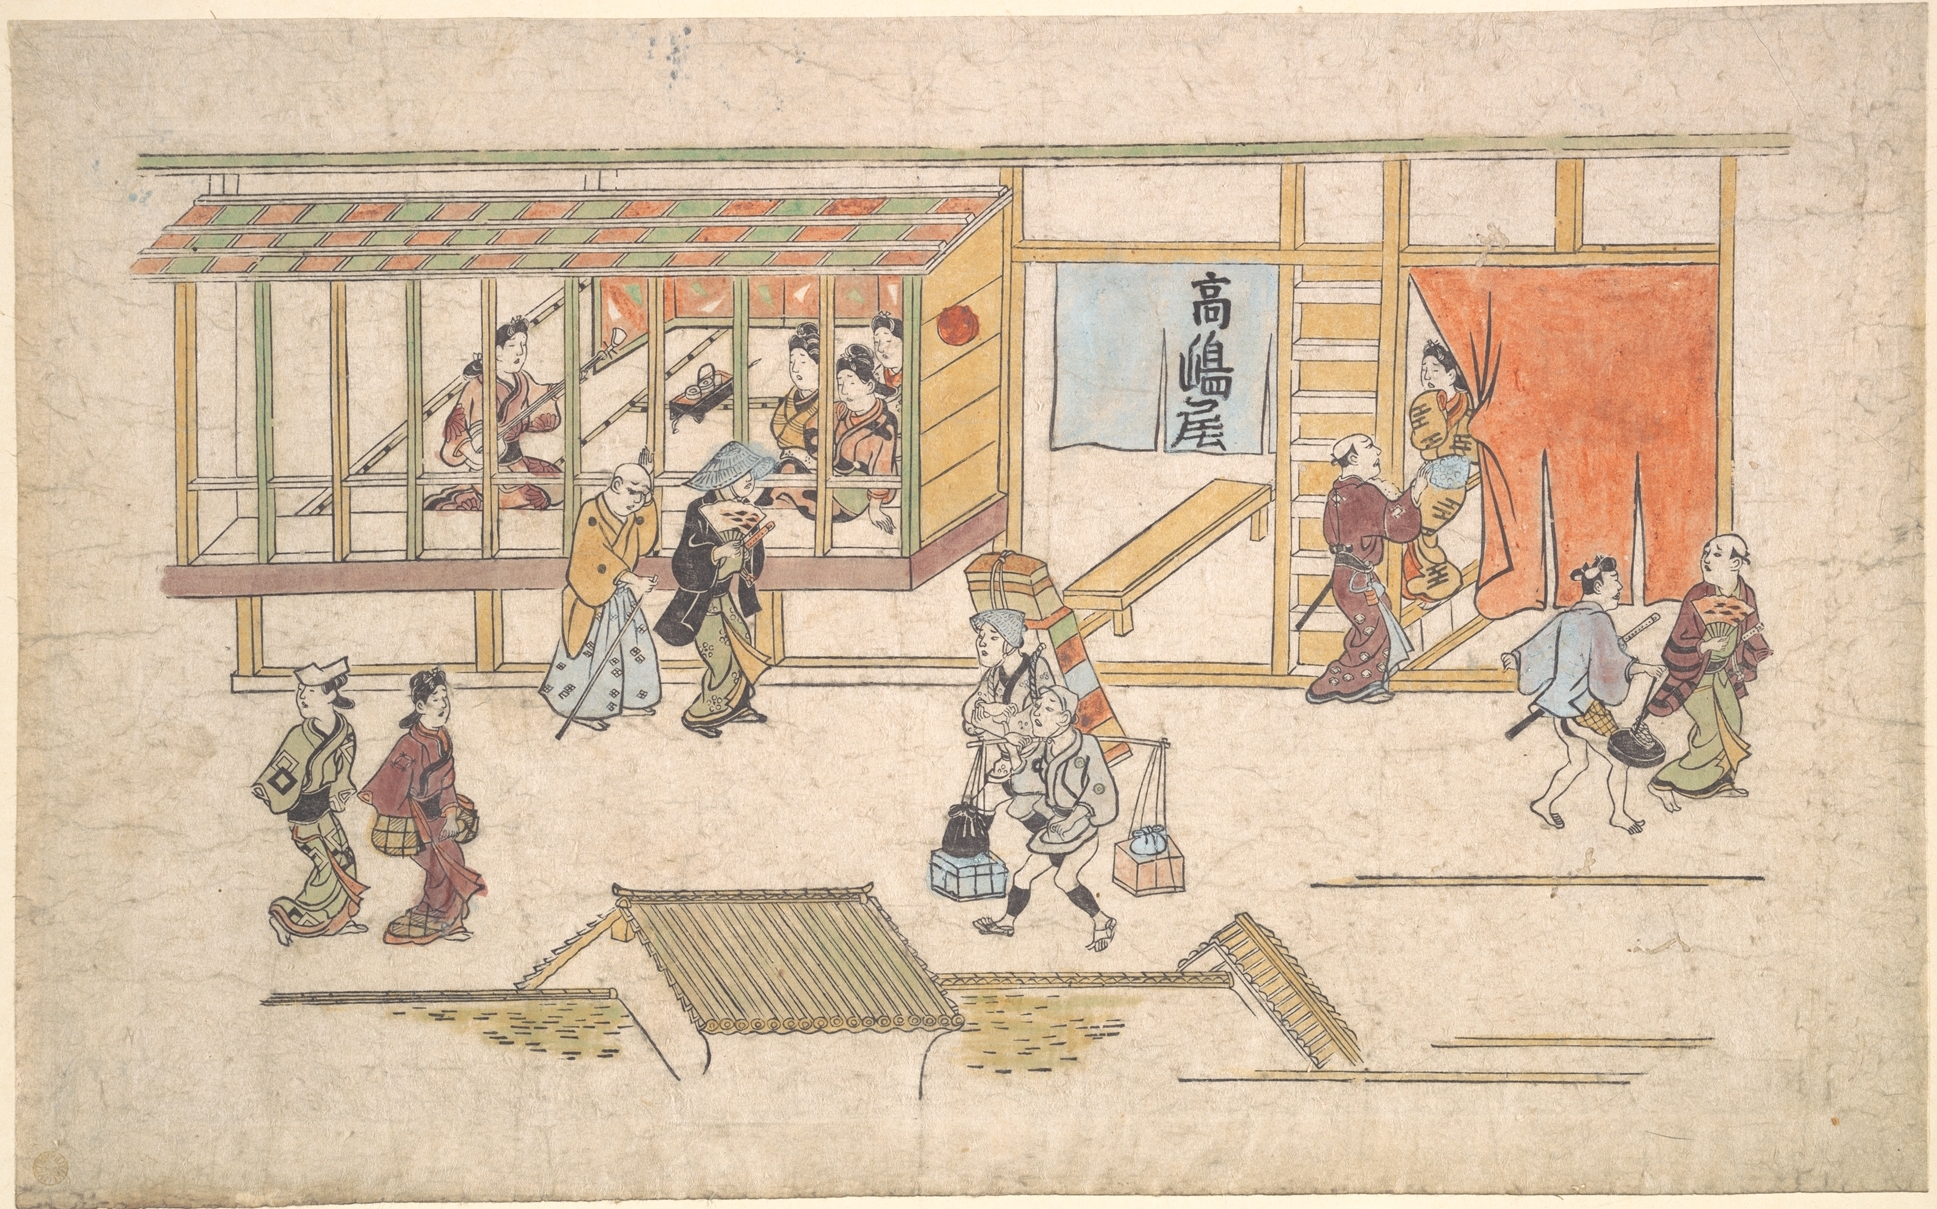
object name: print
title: Scene in the Yoshiwara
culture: japanese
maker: hishikawa moronobu 菱川師宣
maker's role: artist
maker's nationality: japanese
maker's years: 1618-1694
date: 1680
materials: ink, paper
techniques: woodblock print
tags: musical instruments,men,women,working